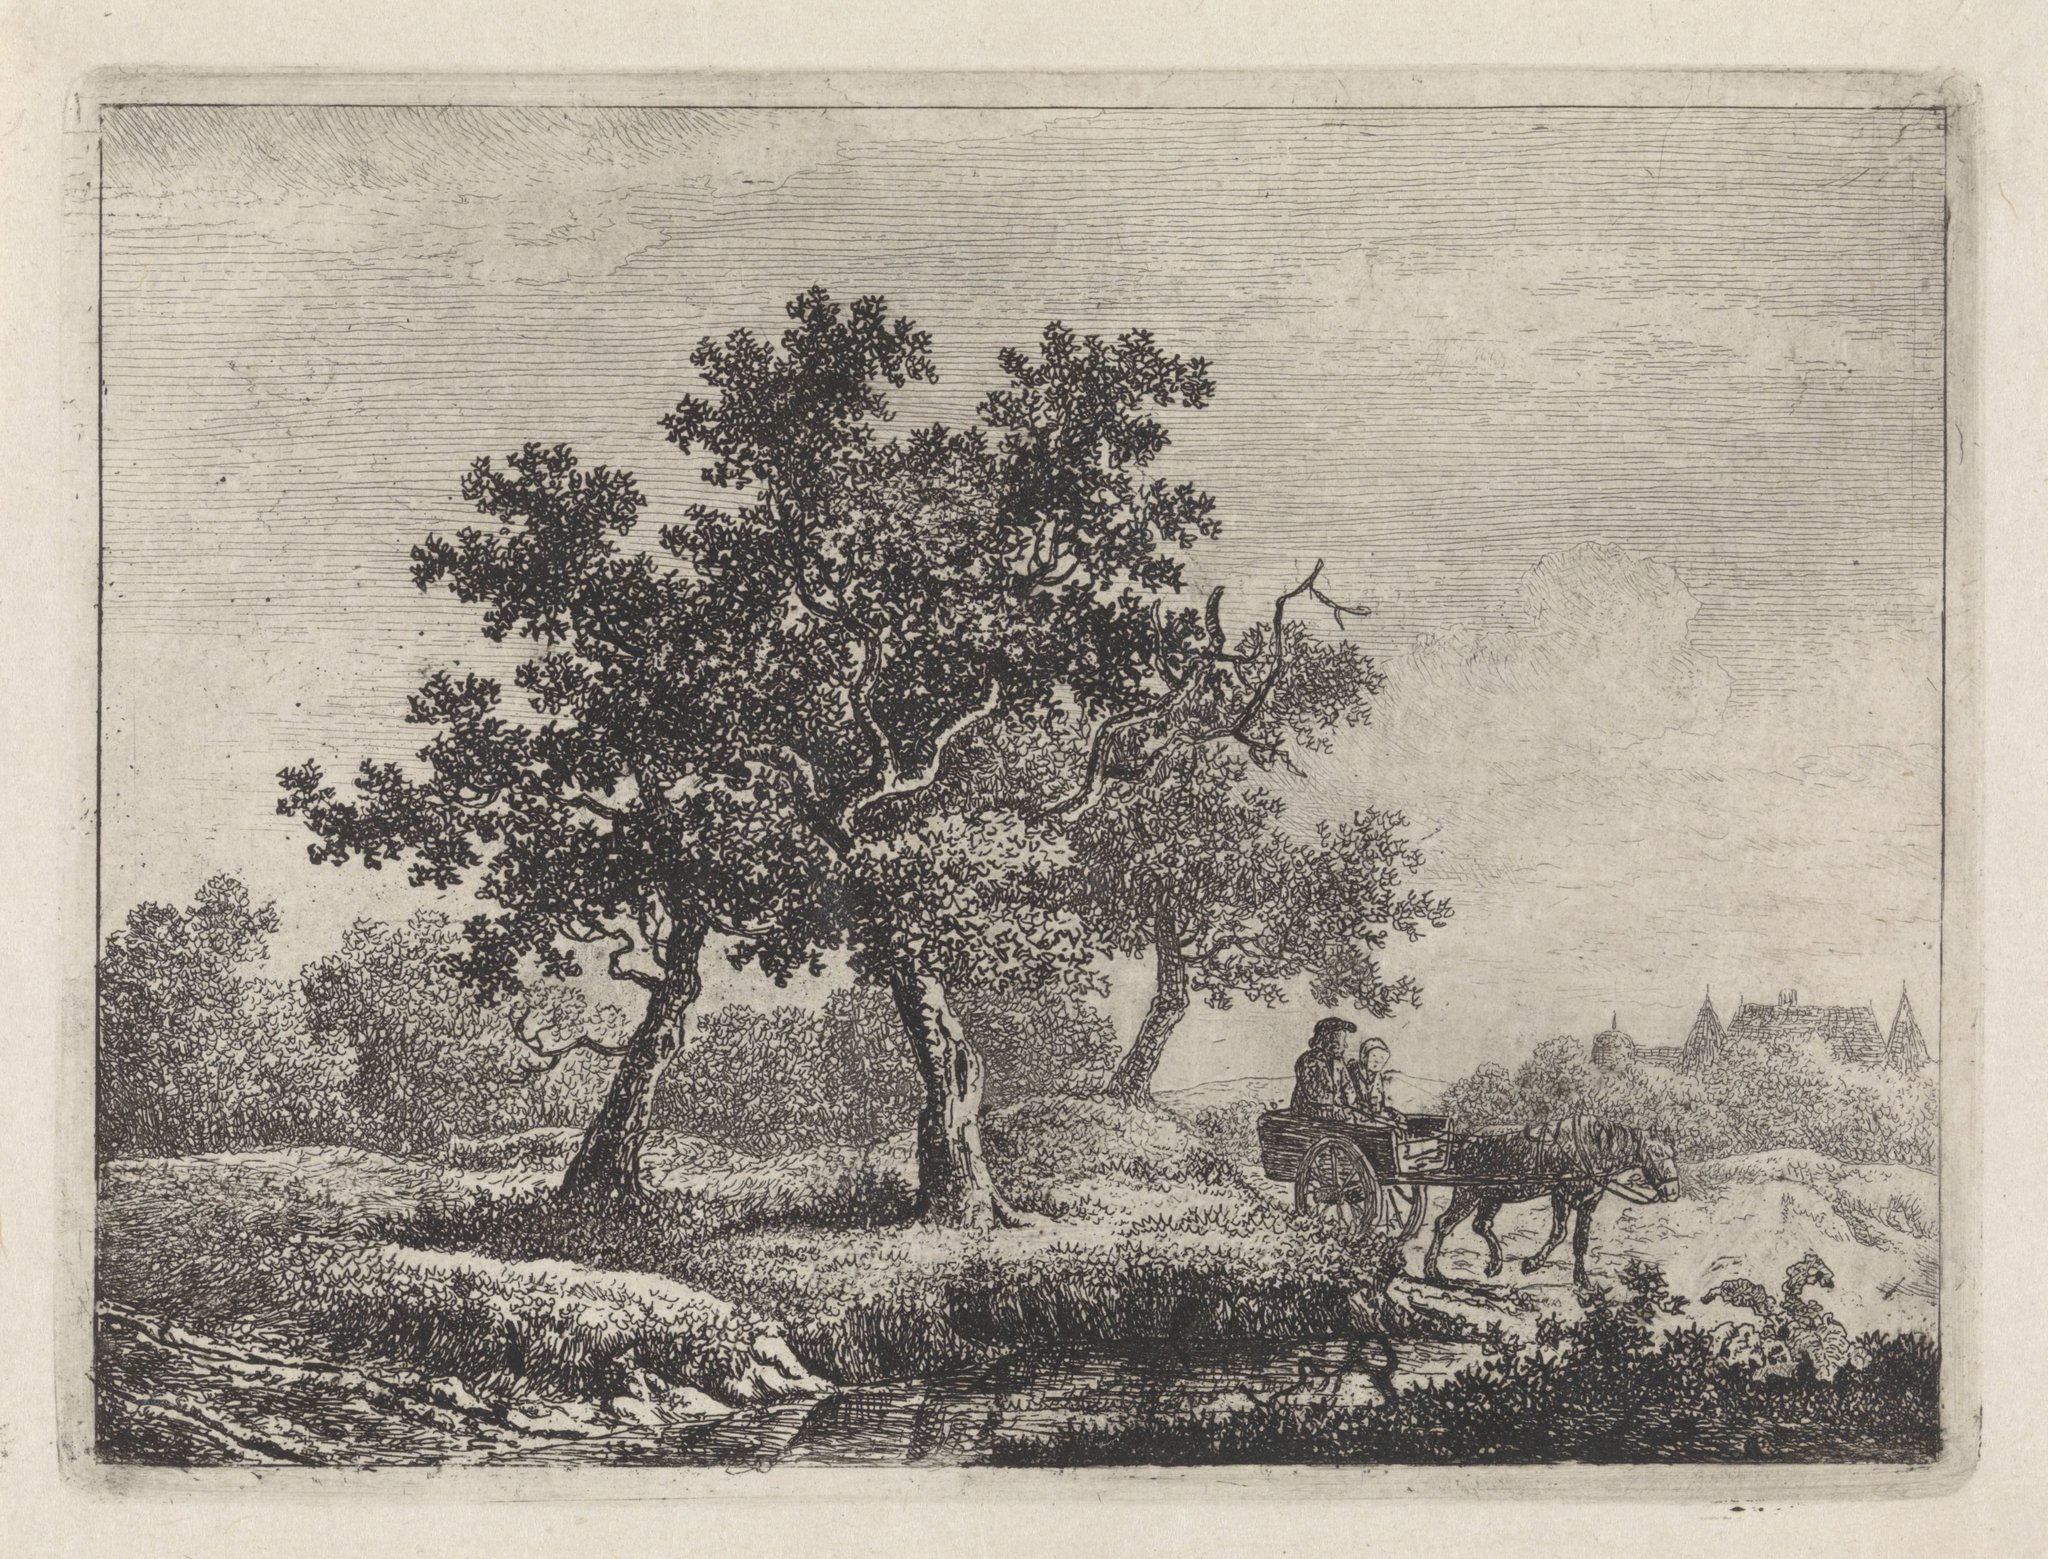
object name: print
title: Landschap met boerenkar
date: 1778-1823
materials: paper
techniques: etching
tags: landscapes (+ landscape with figures, staffage), (farm) wagon, freight wagon, cart (+ variant)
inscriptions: collector's mark: Lugt 240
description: Landschap met op de voorgrond drie bomen aan het water. Rechts een boerenkar met een man en een vrouw. De kar wordt getrokken door een paard. Op de achtergrond een dorp.